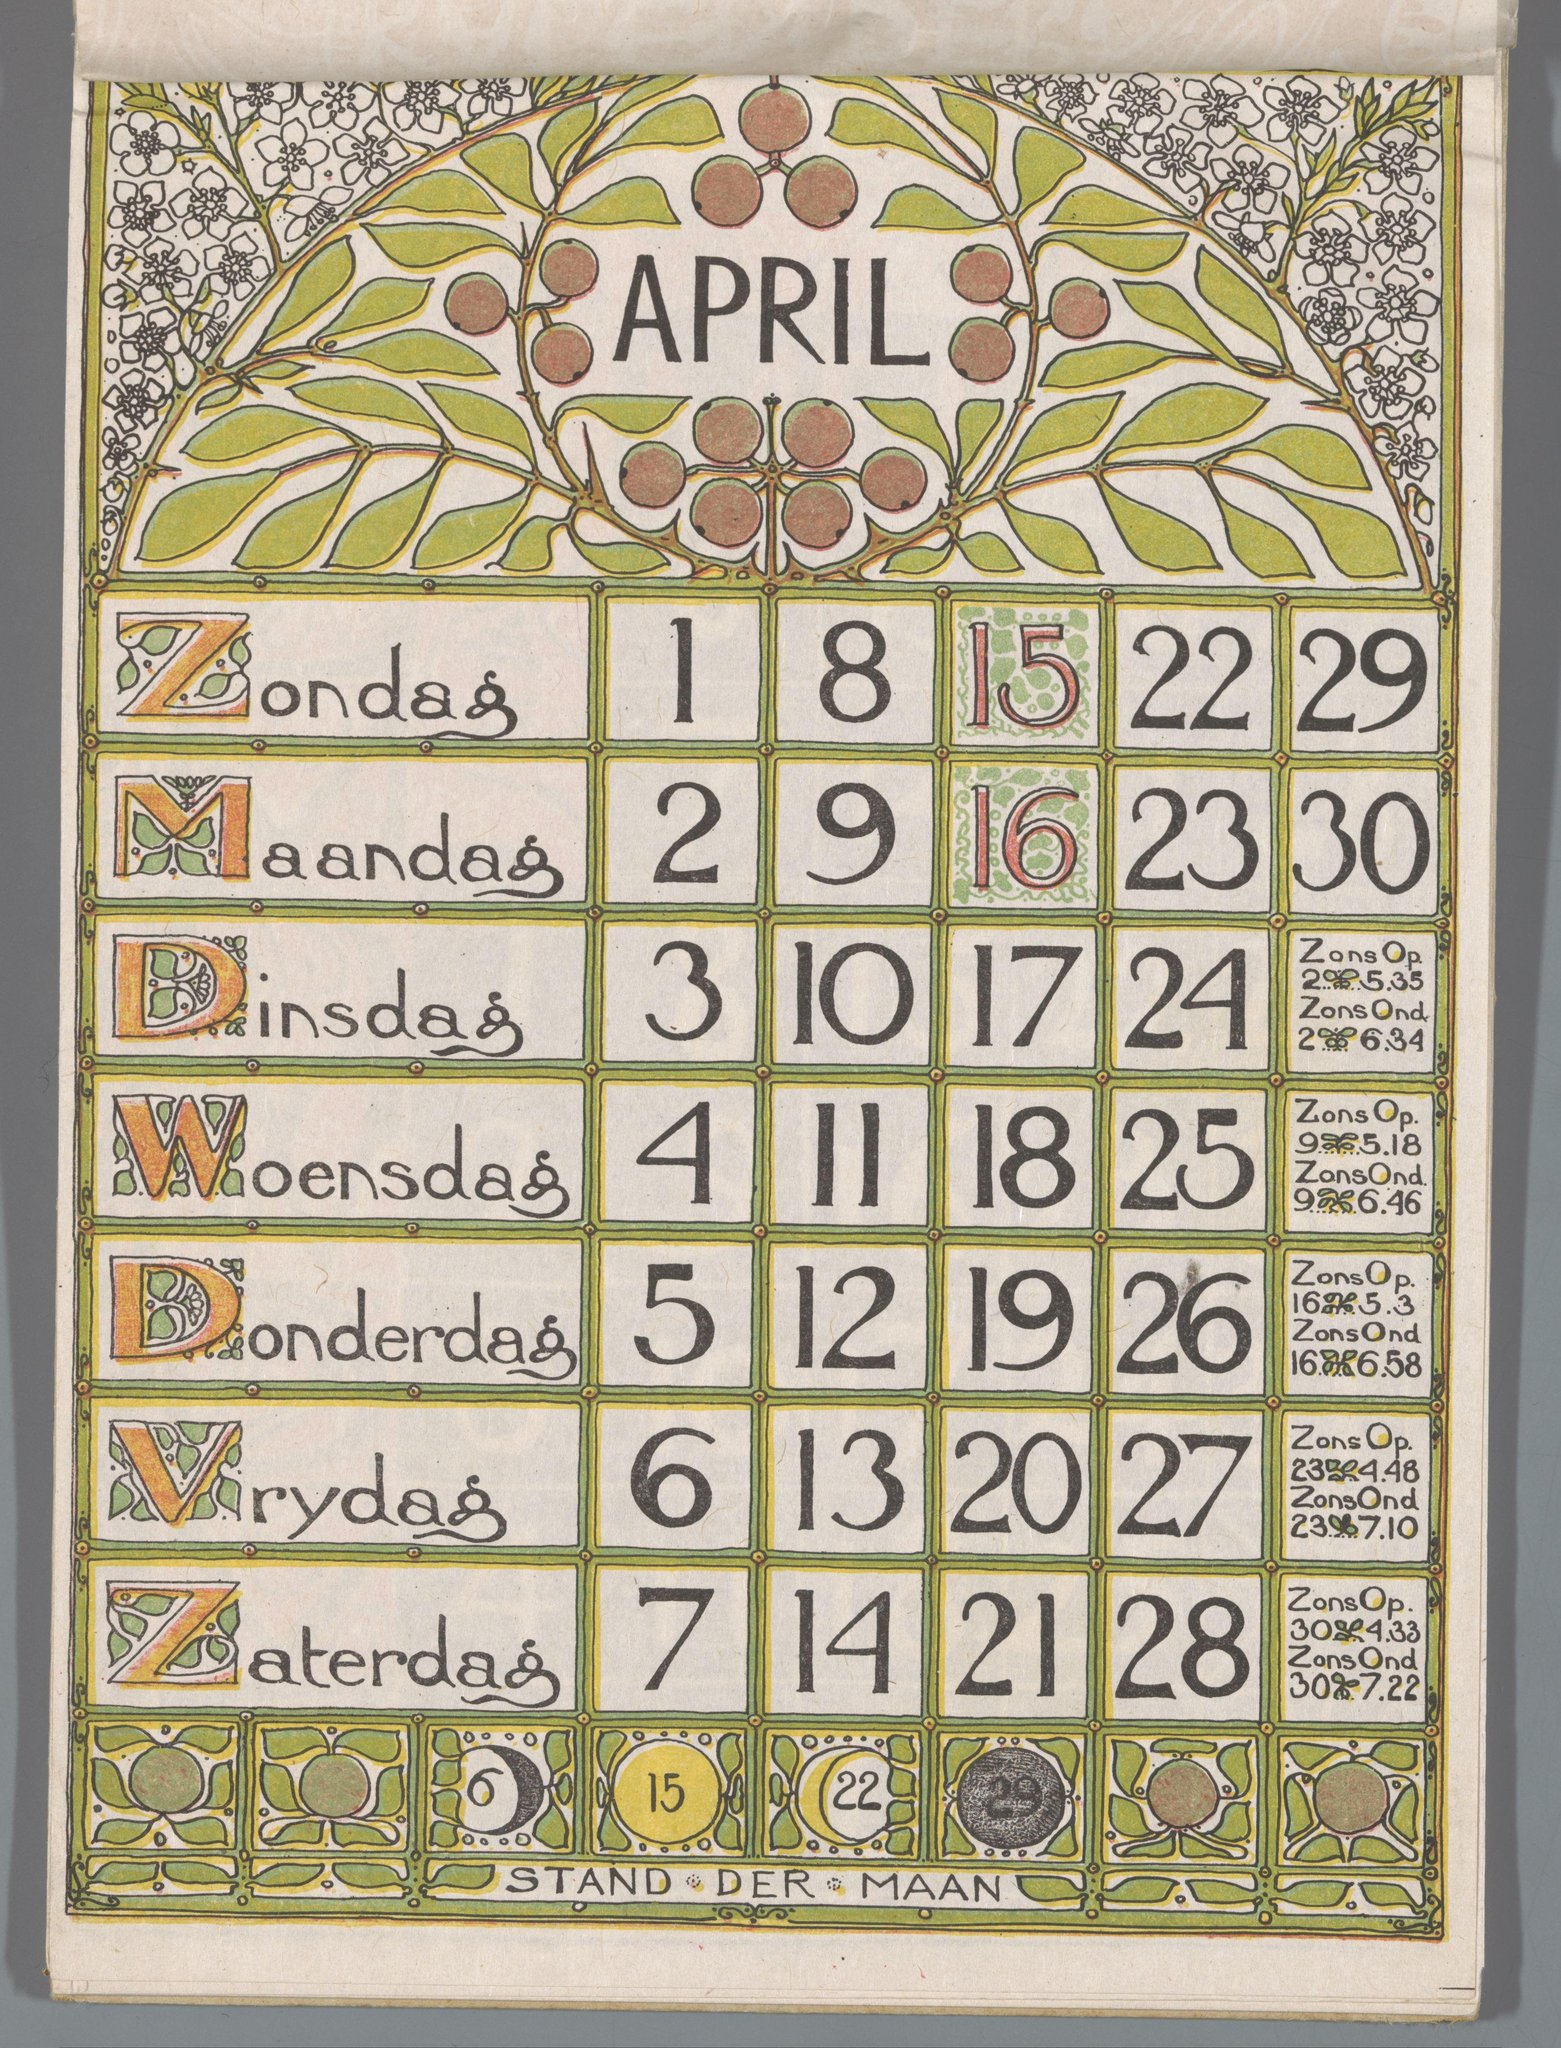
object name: calendar leaf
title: Kalenderblad april 1900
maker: theo nieuwenhuis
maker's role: designer, draughtsman, print maker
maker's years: 1866-1951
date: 1900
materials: paper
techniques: lithograph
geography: amsterdam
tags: april ~ other concepts